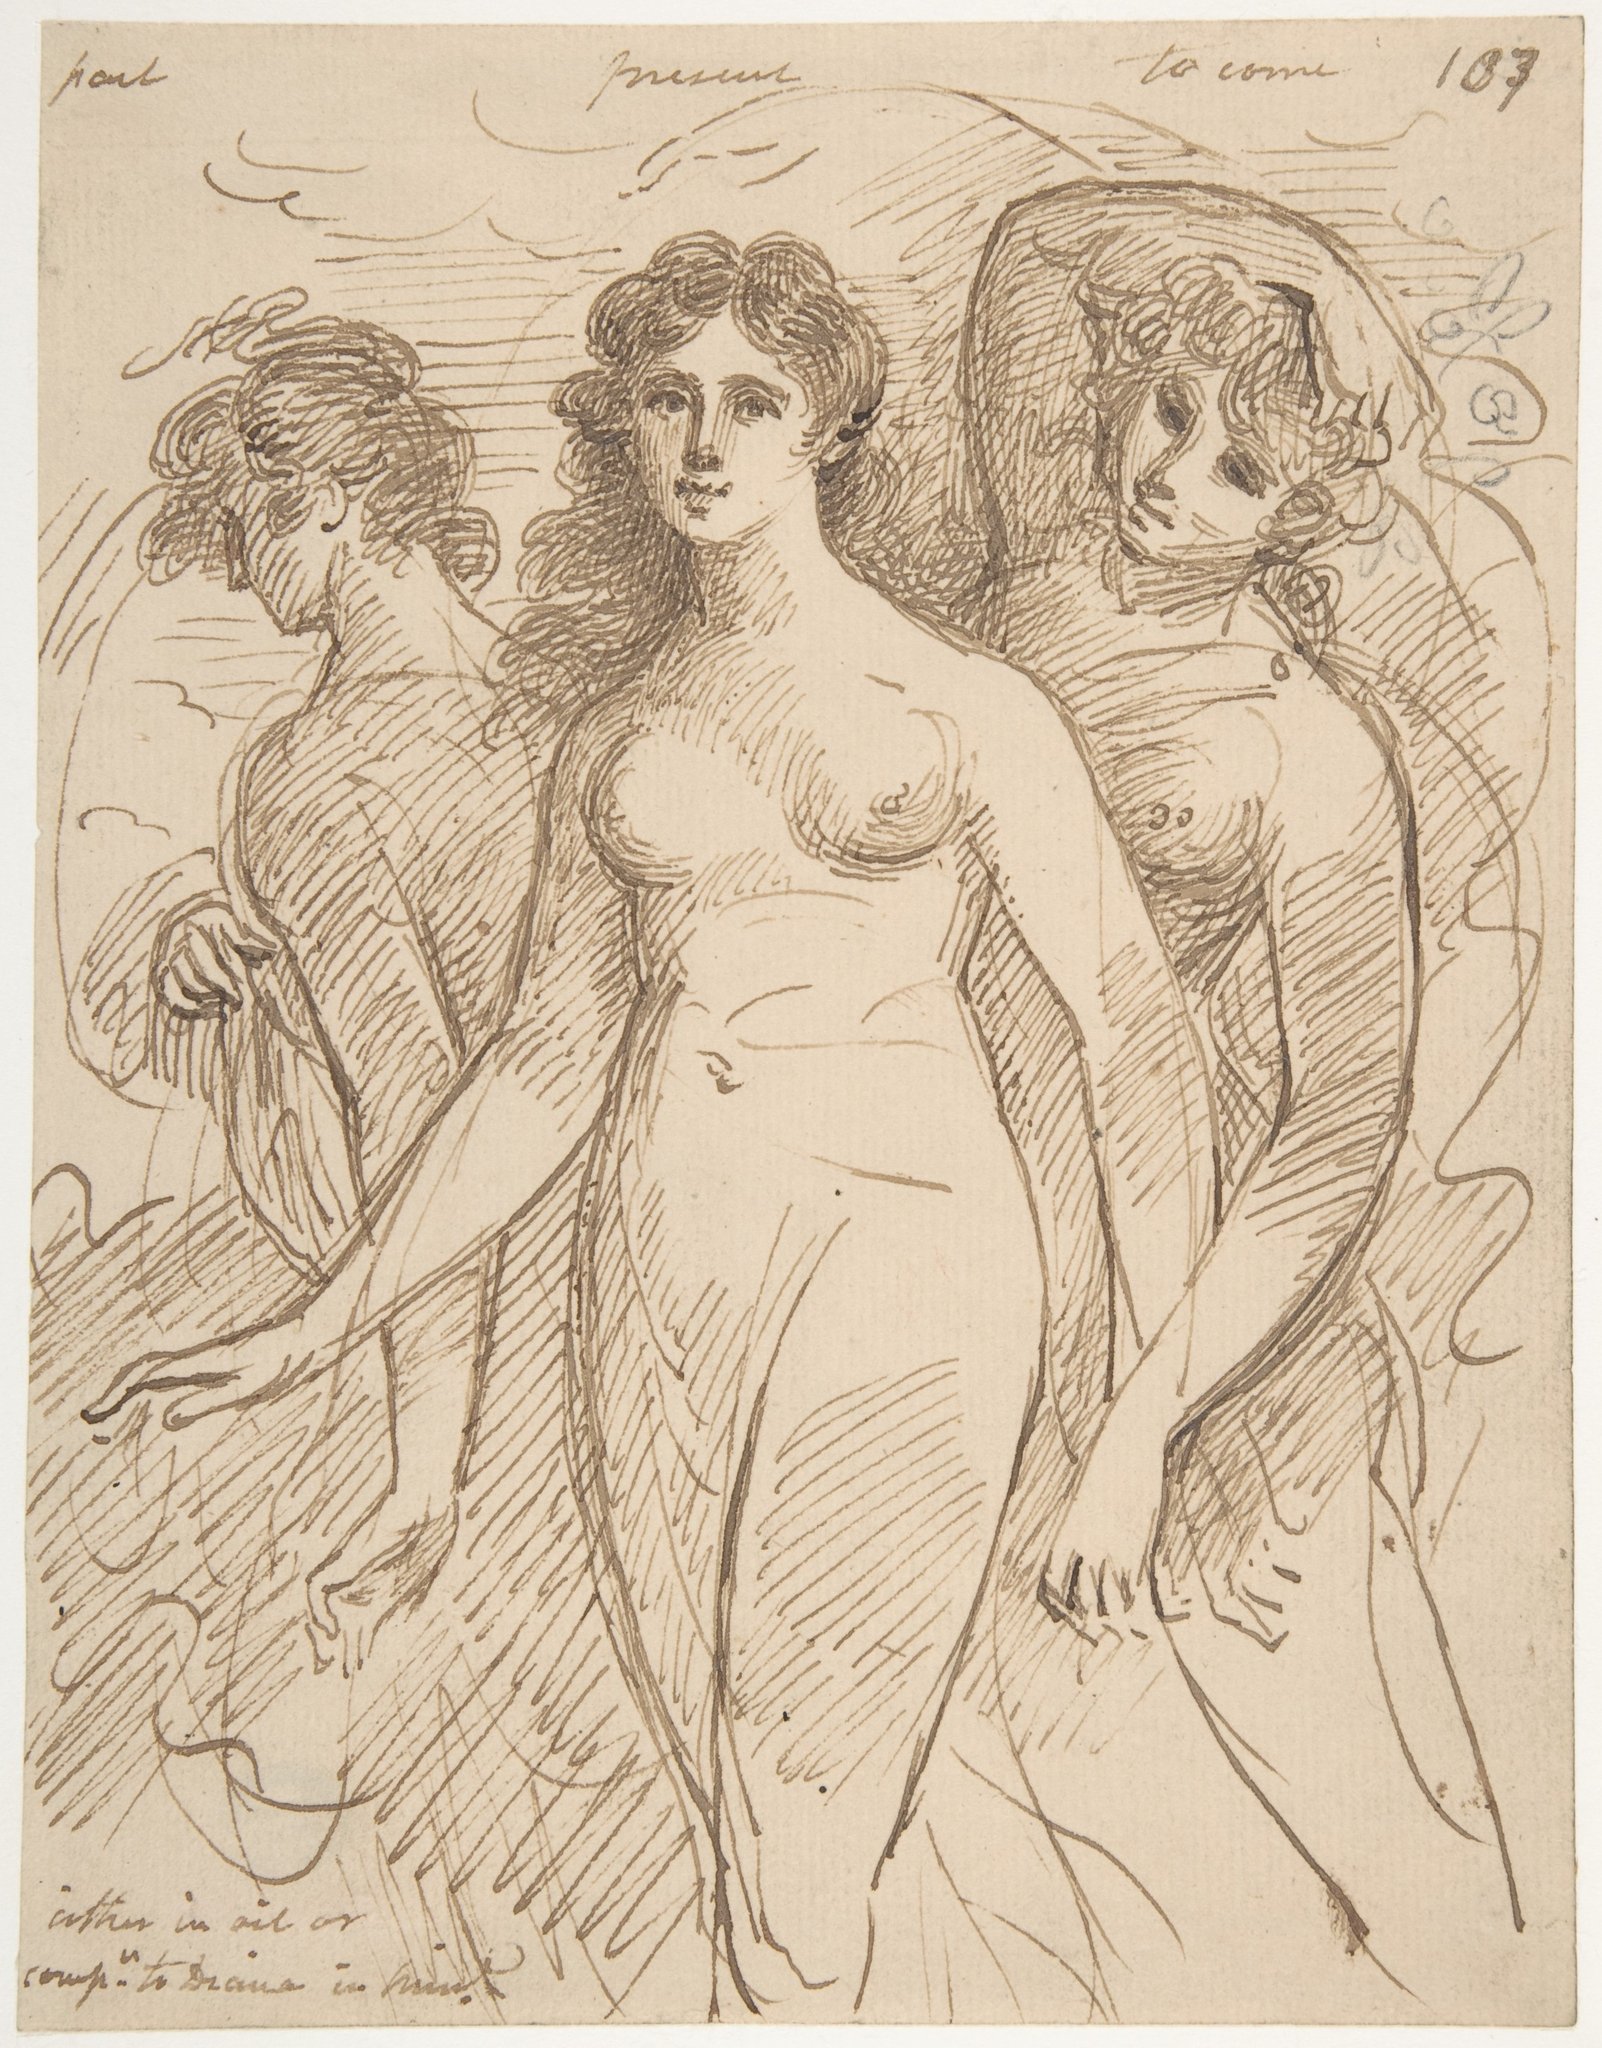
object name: drawing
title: The Hours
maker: samuel shelley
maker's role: artist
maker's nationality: british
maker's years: 1756-1808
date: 1800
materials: ink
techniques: pen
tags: female nudes